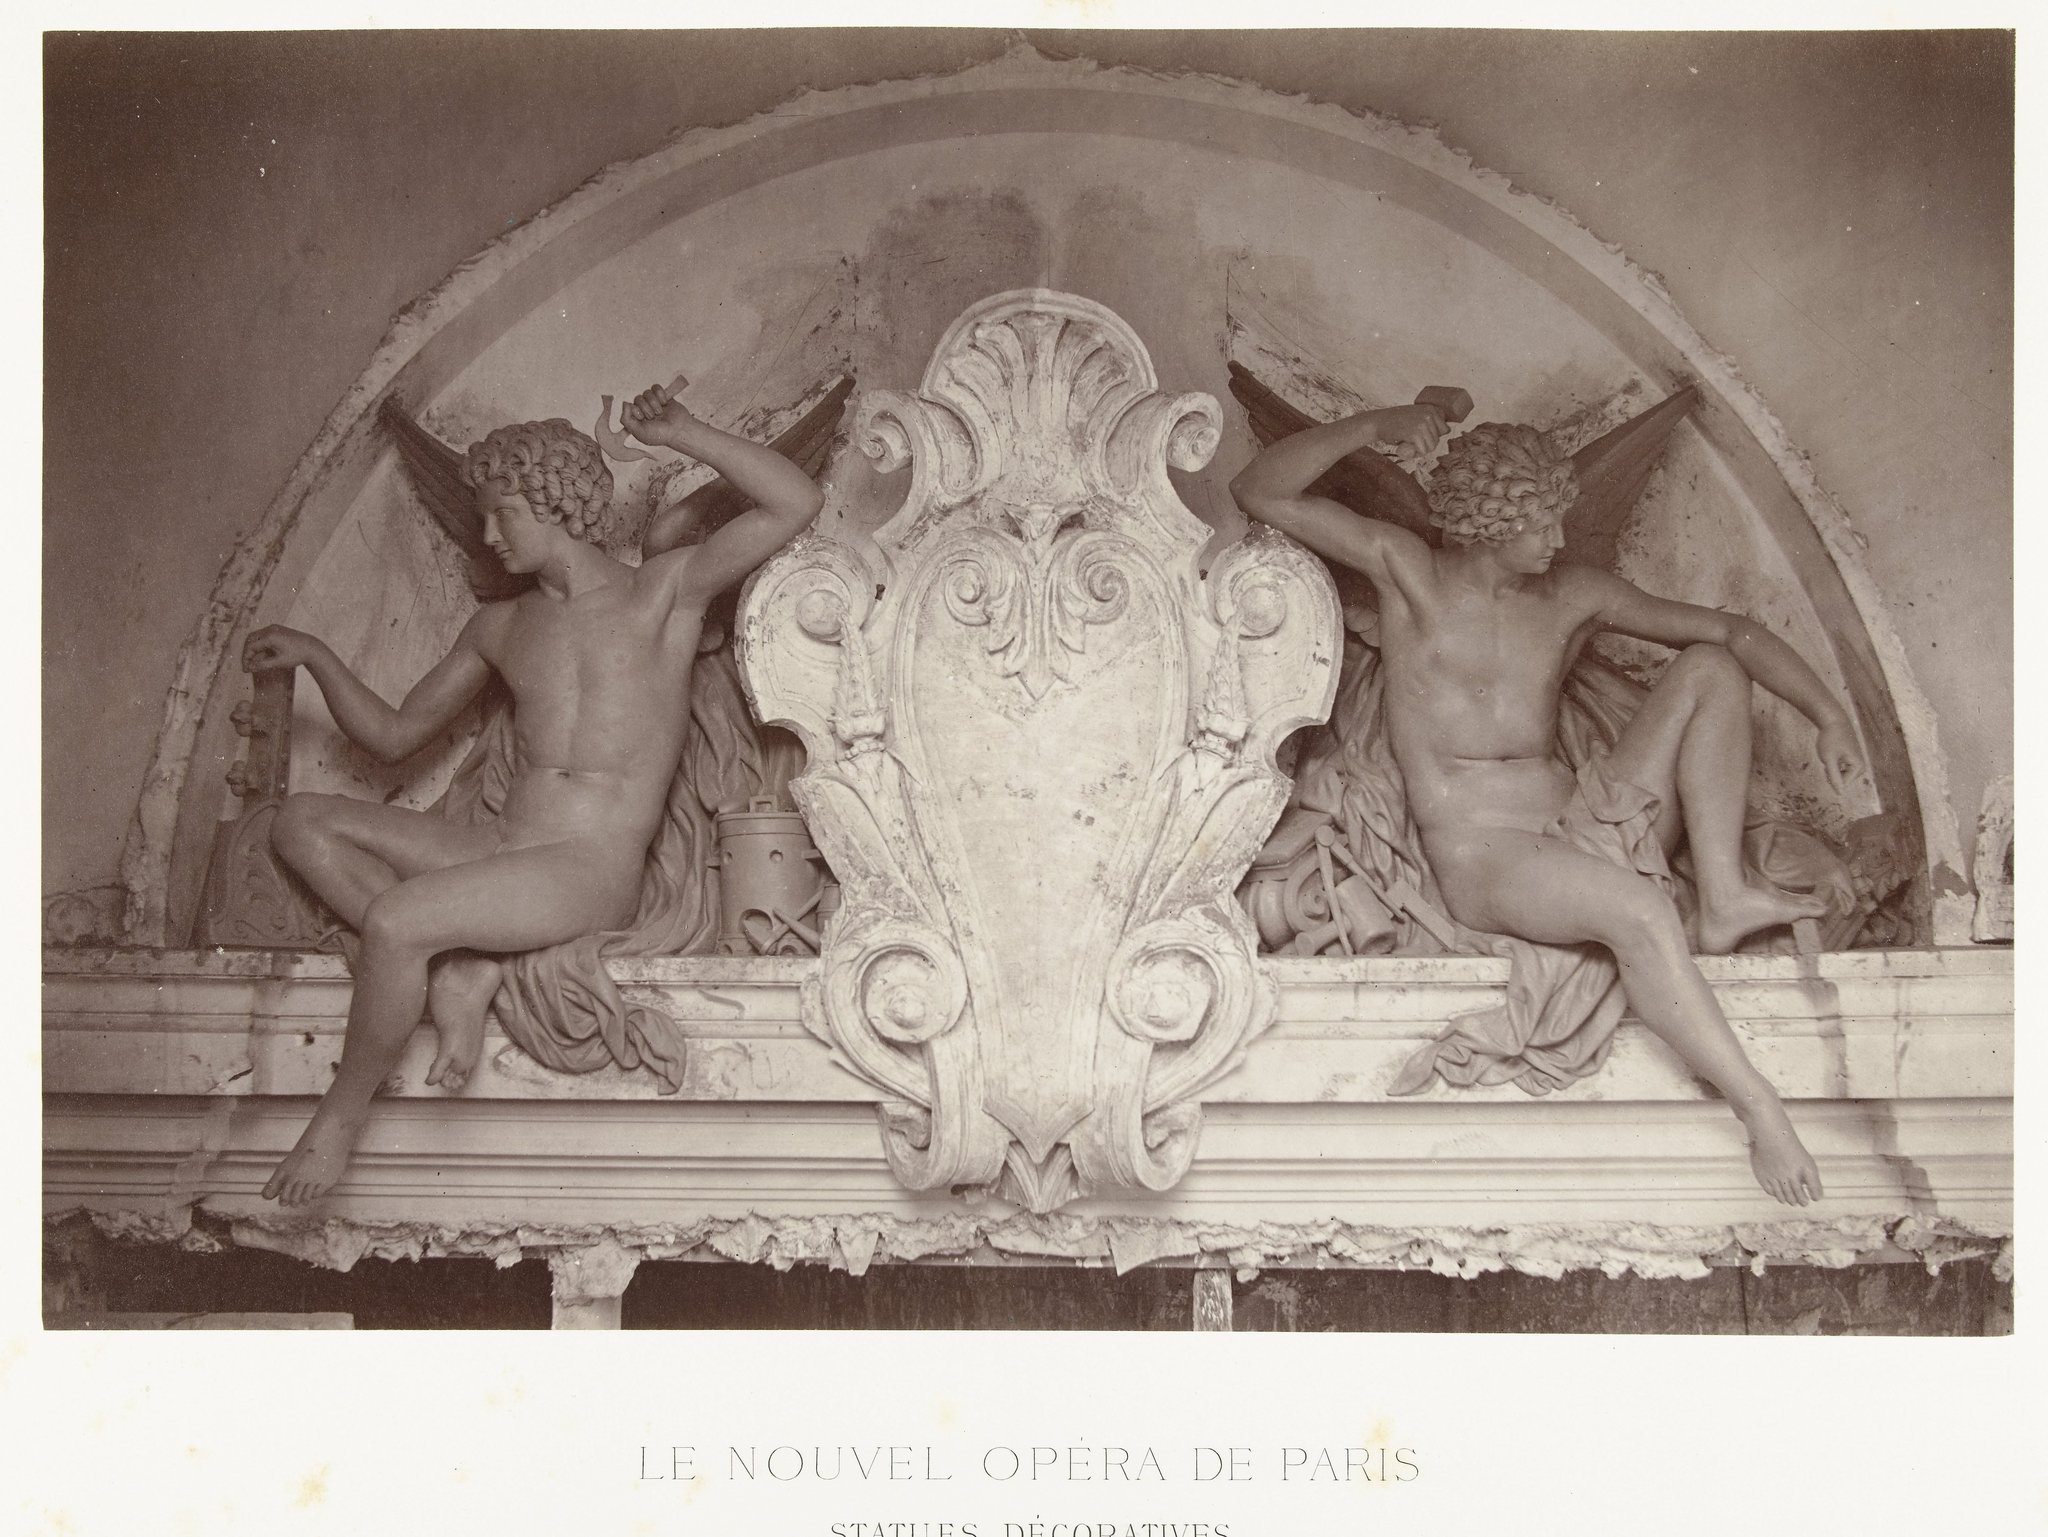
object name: photograph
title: Twee beelden van mannelijke engelen met een hamer in de hand, zittend aan weerszijden van een medaillon, gesitueerd boven een deurpartij.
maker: louis-emile durandelle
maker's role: fotograaf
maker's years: 1839-1917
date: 1878-1881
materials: photographic support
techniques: albumen print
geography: paris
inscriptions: number: ‘29’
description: bij boek in Bibliotheek RMA, Zie Frizot, pp. 217-223, vgl G. Vicaire, Manuel de l'amateur de livres du XIXe siècle, vol. 3, column 870.